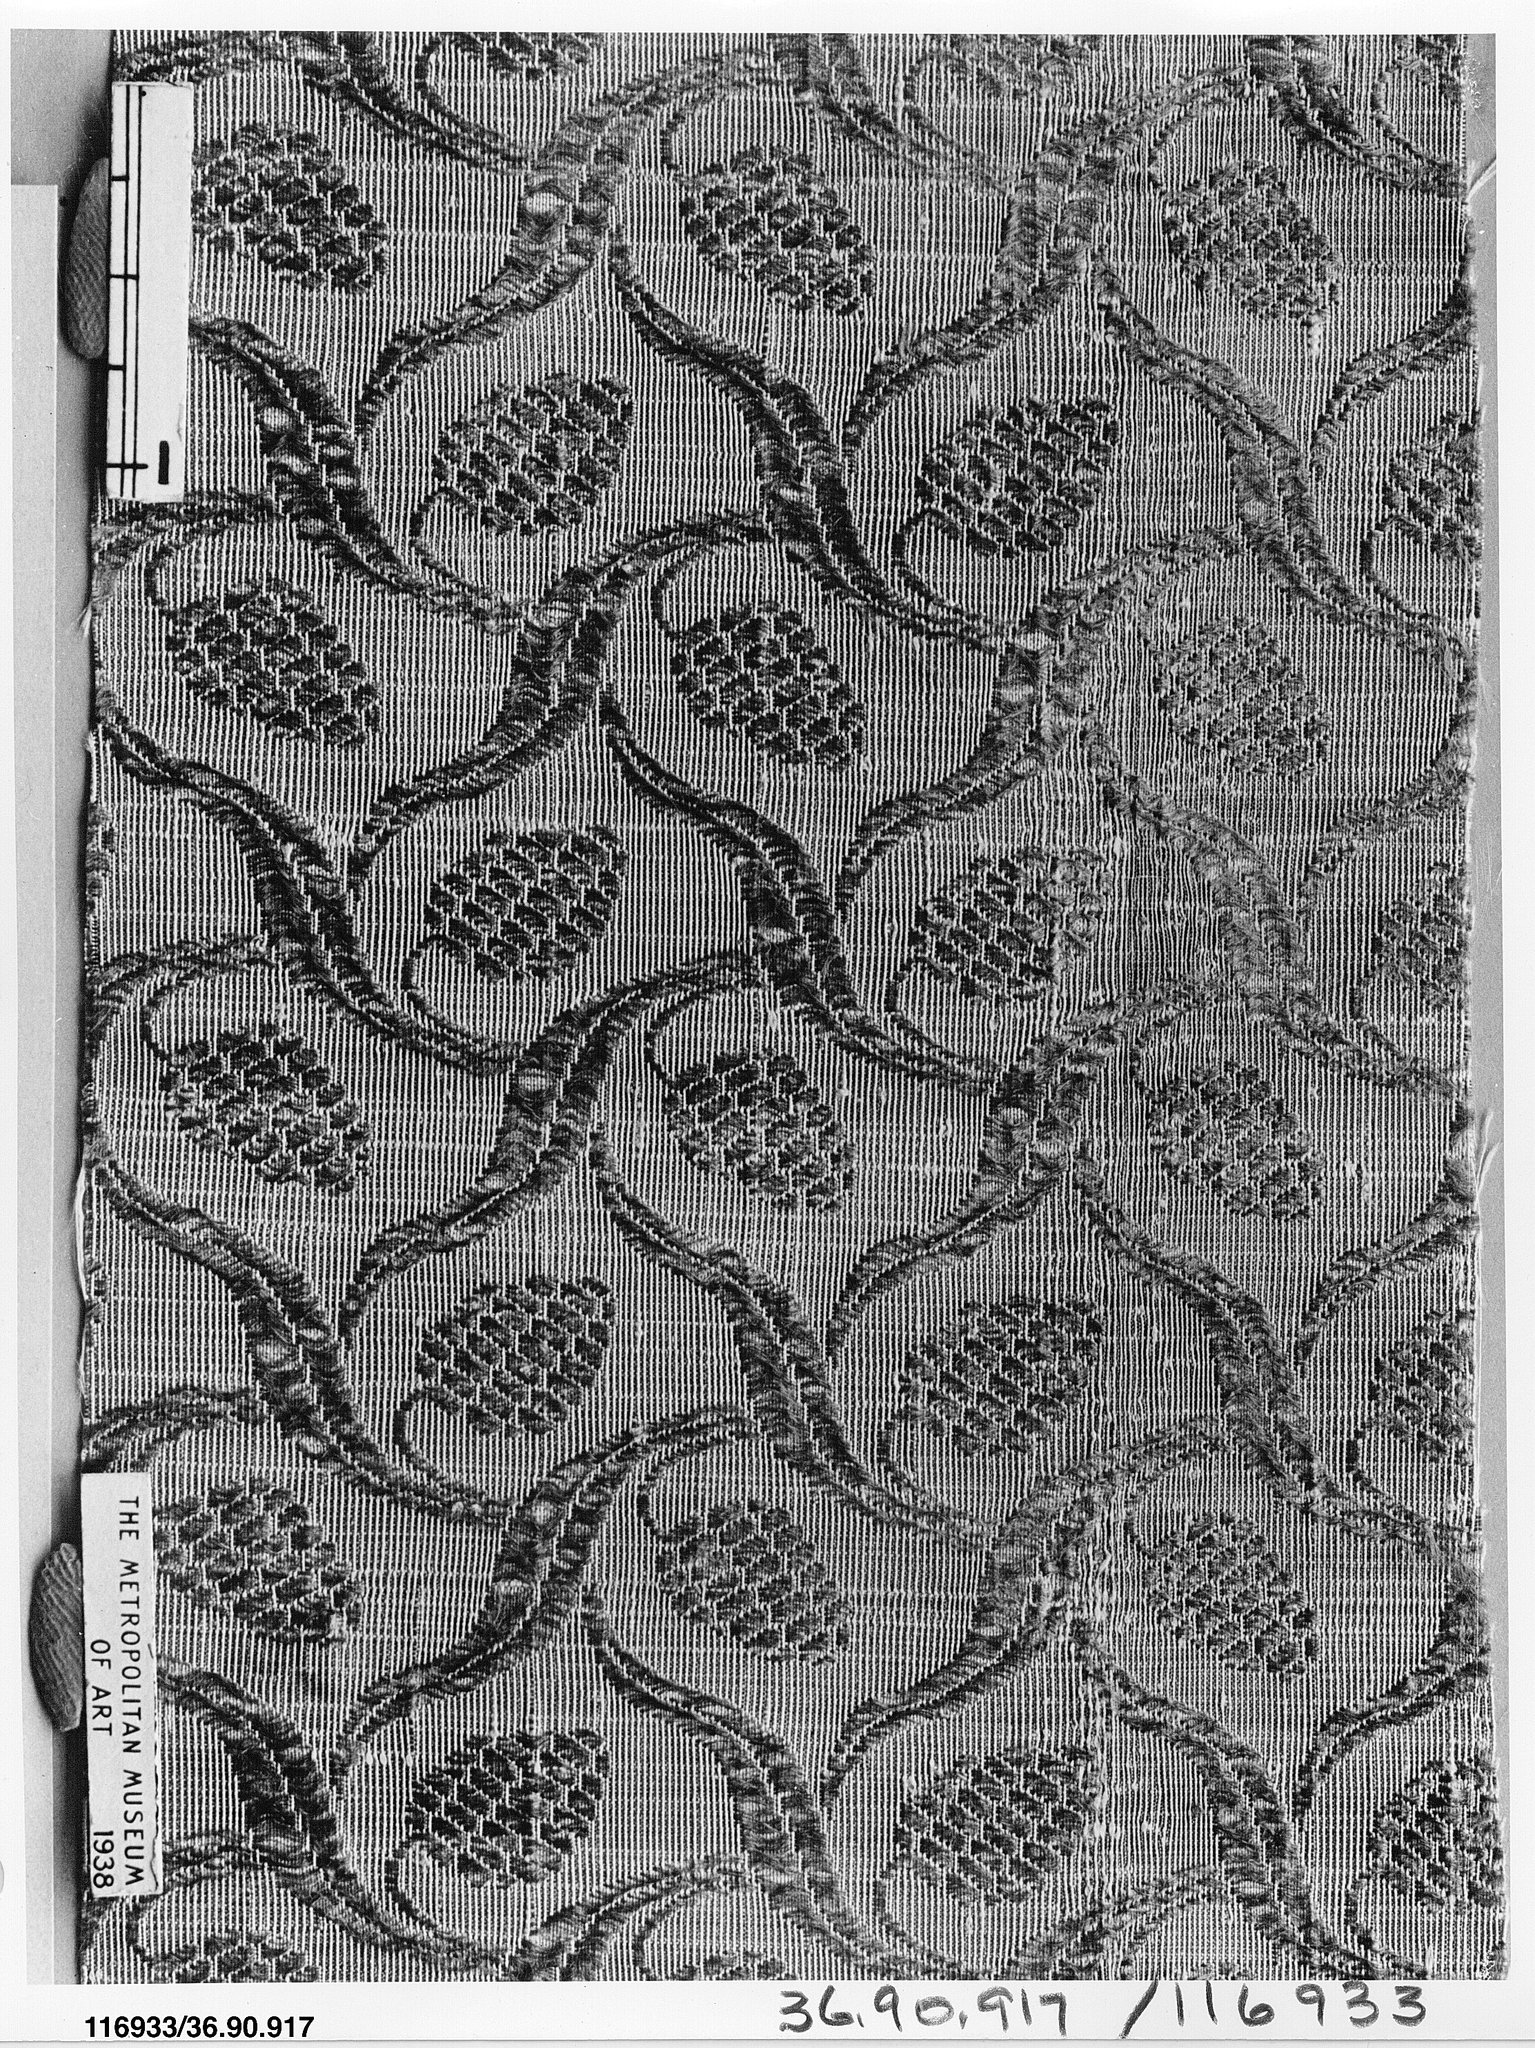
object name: piece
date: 1701-1800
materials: silk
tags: leaves